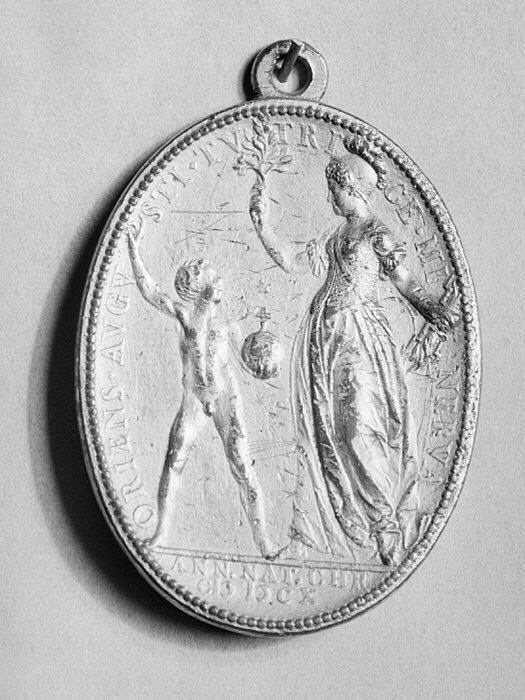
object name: medal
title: Louis XIII (b. 1601, r. 1610–43), King of France, as youth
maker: guillaume dupré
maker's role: artist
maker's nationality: french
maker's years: 1579-1640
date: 1610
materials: gilt bronze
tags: male nudes,women